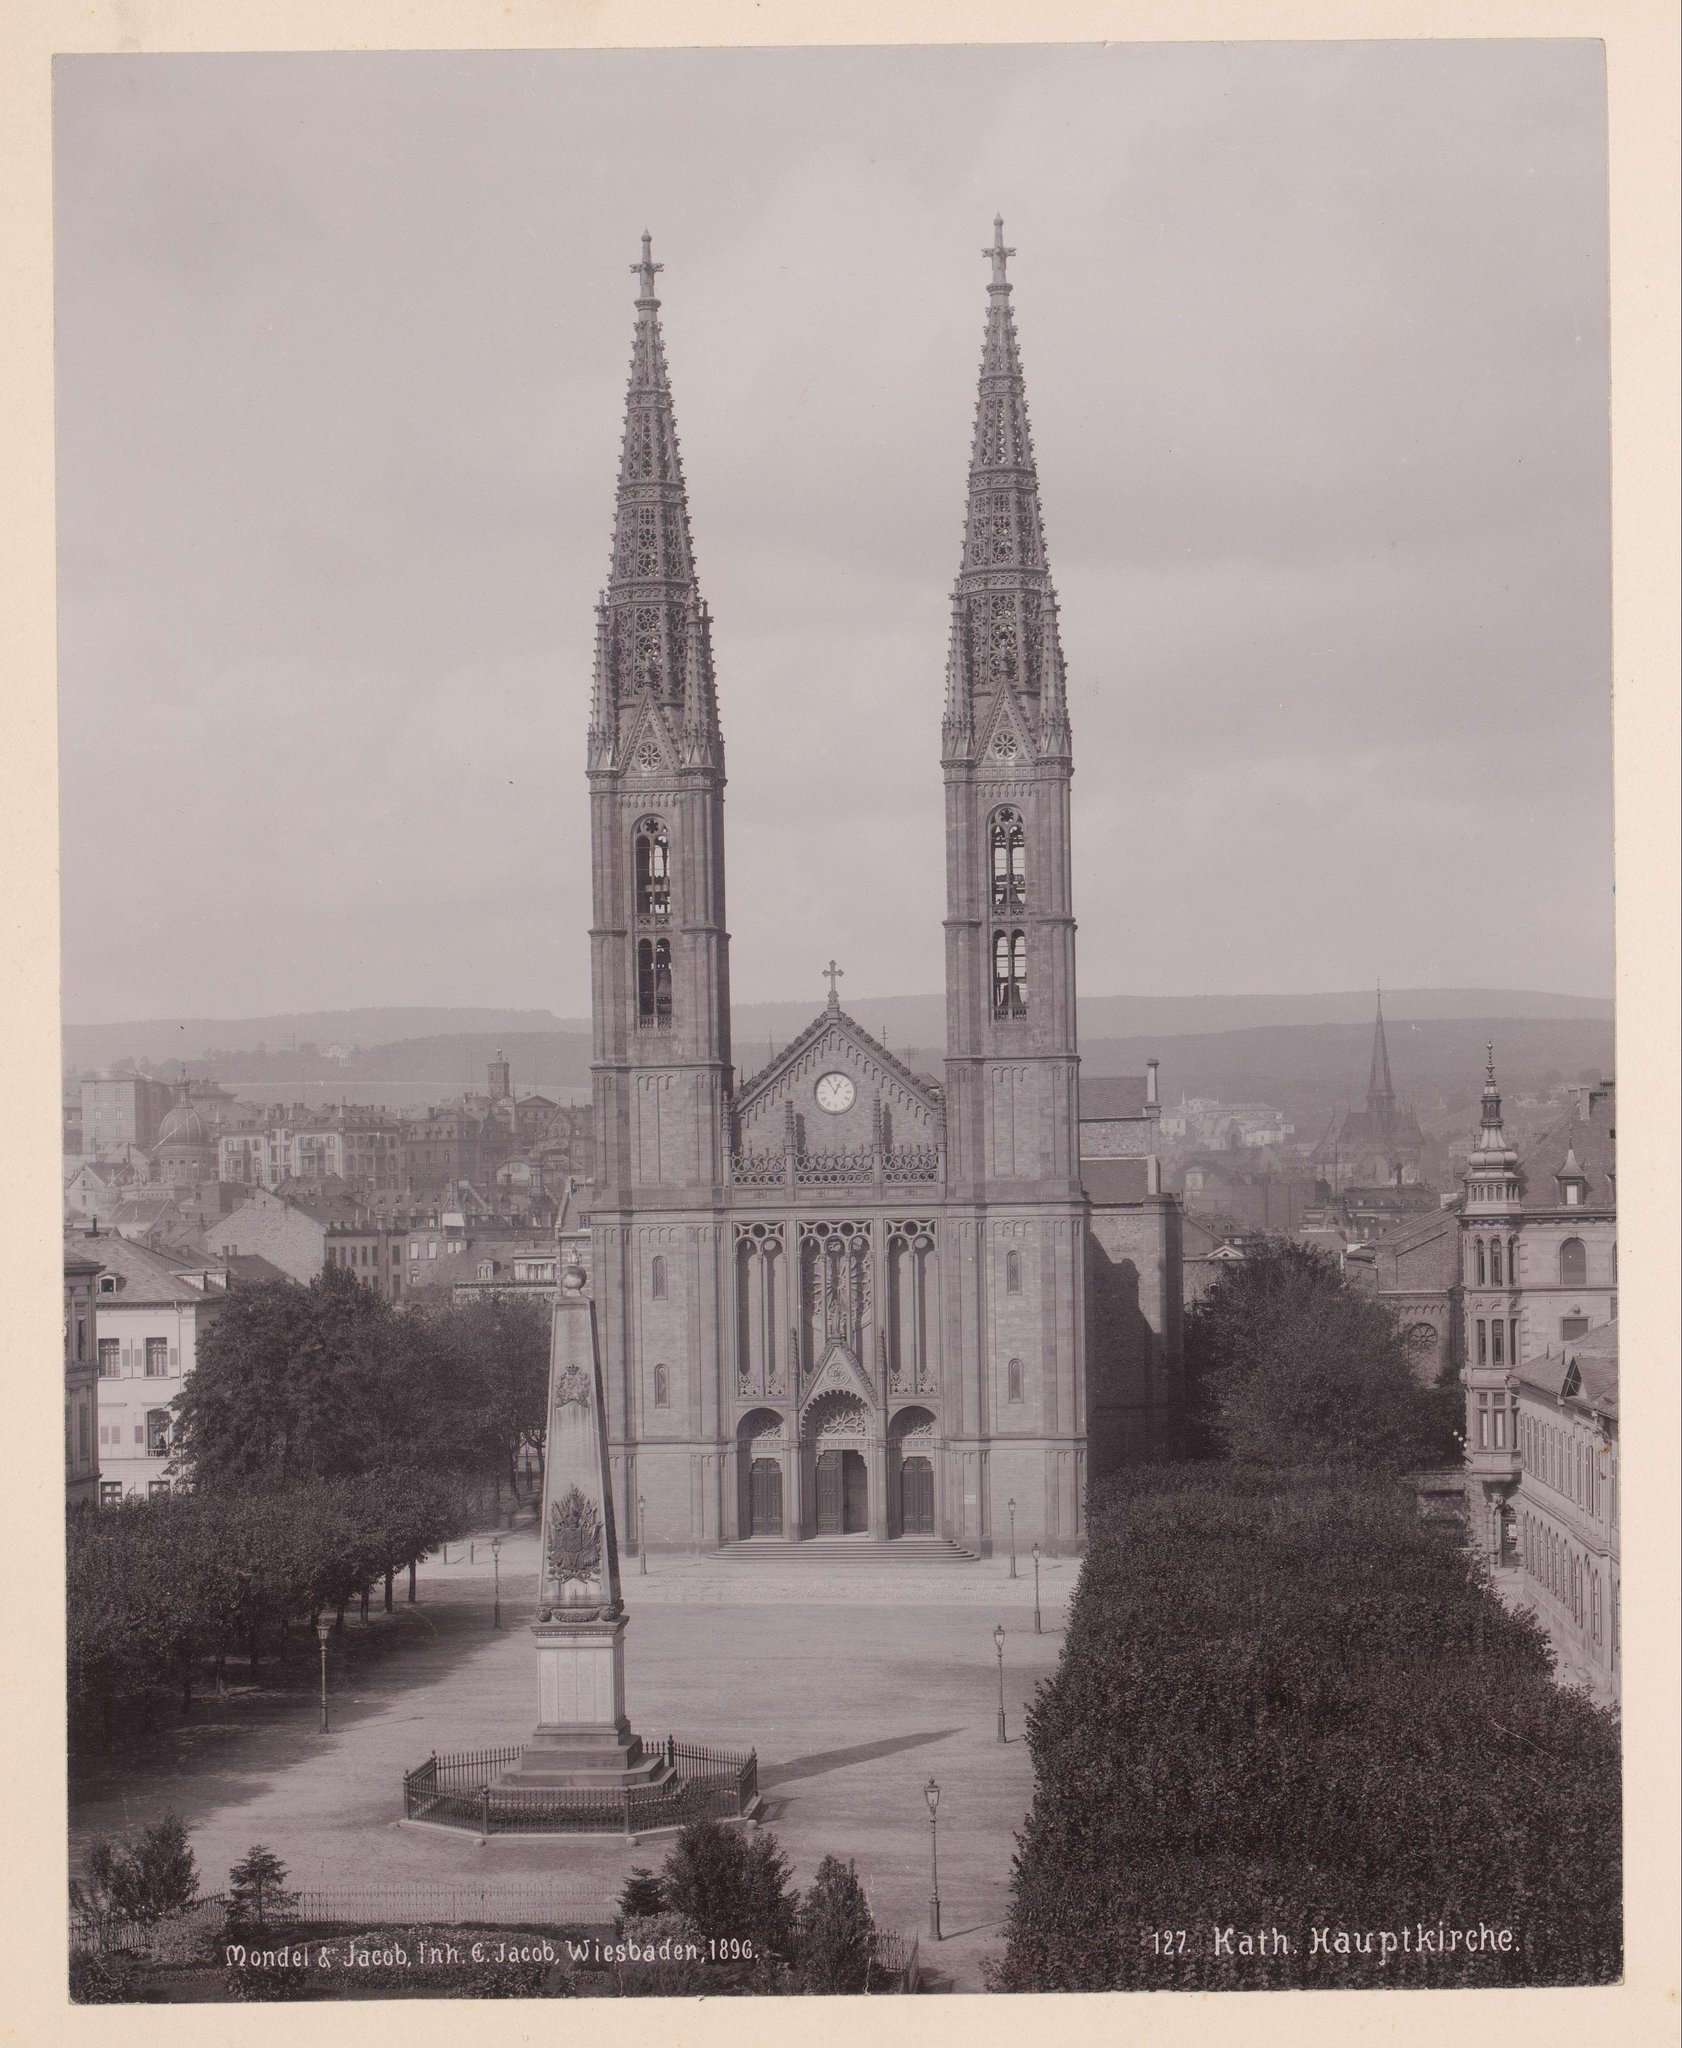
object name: photograph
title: "Katholische Hauptkirche", Wiesbaden, Duitsland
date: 1896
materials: cardboard, paper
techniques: gelatin silver print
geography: wiesbaden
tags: wiesbaden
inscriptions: date, inscription: ‘Mondel & Jacob Inh. G. Jacob, Hof-Phot. Wiesbaden 1896.’, inscription: ‘127. Kath. Hauptkirche.’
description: Frontaal aanzicht op de kerk en het lege plein ervoor vanuit een hoog standpunt.